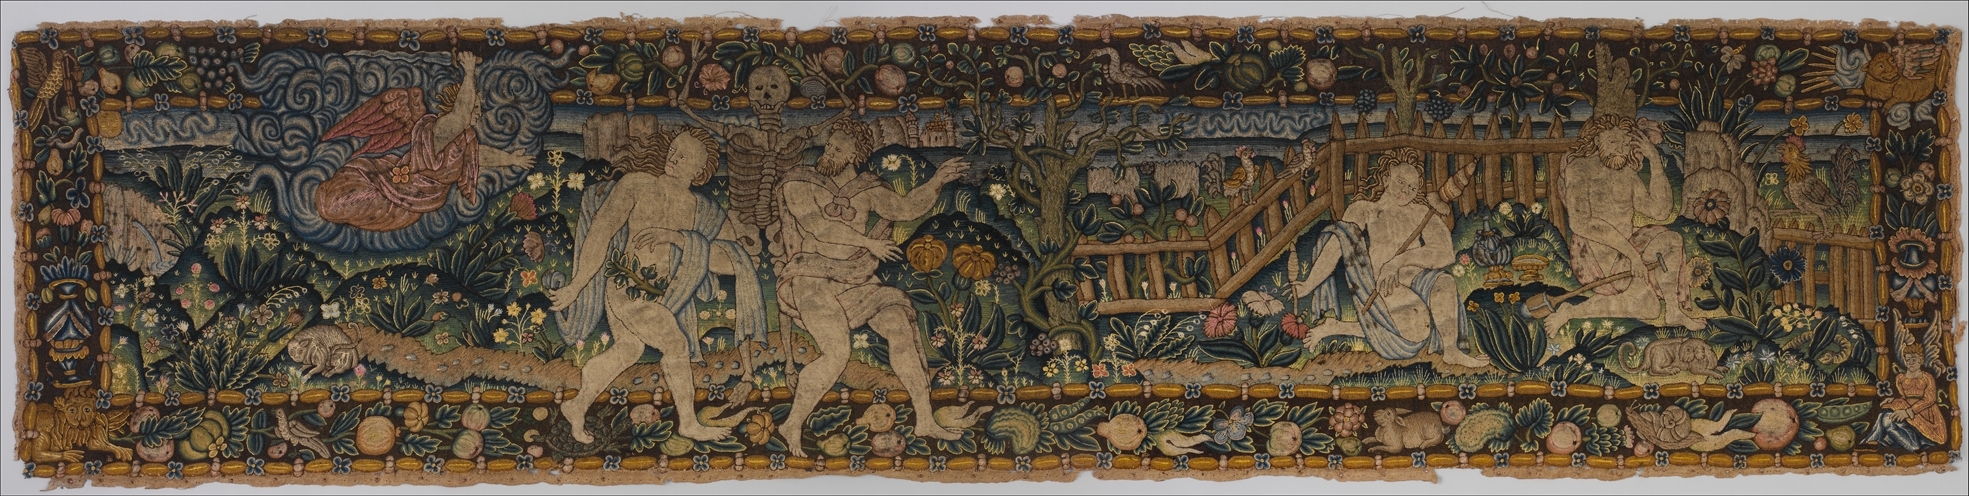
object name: bed valance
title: The Expulsion and Adam and Eve after the Fall (one of a set of three)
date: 1567-1600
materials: canvas, metal thread, silk, wool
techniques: stitching, weave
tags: birds,skeletons,angels,adam,eve